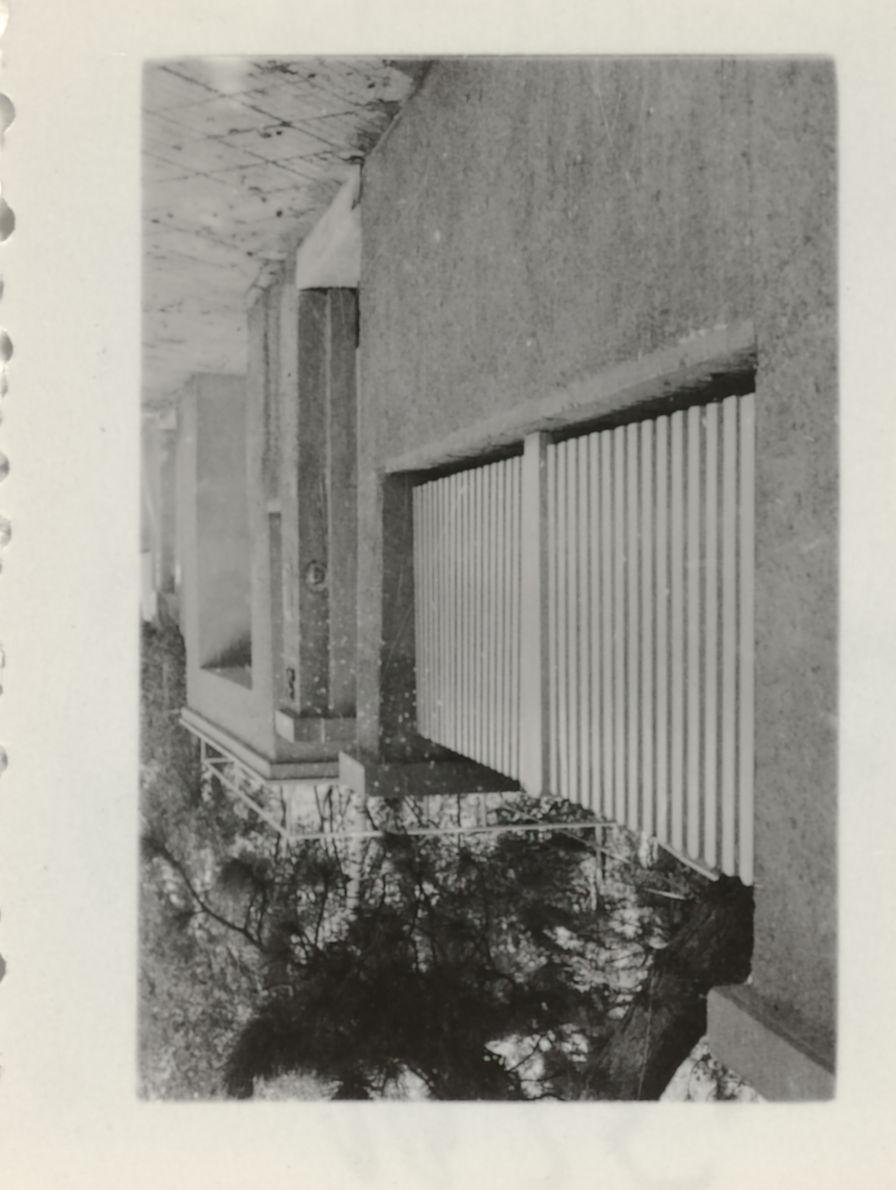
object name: photograph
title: Schuin aanzicht van een stenen muur met daarop een hekwerk, met bomen op de achtergrond en een stoep op de voorgrond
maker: Anonymous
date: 1935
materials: photographic support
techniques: gelatin silver print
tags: stuttgart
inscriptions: inscription: ‘1935. Hauptmanstrasse 32.’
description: Schuin aanzicht van een stenen muur met daarop een hekwerk, met bomen op de achtergrond en een stoep op de voorgrond.